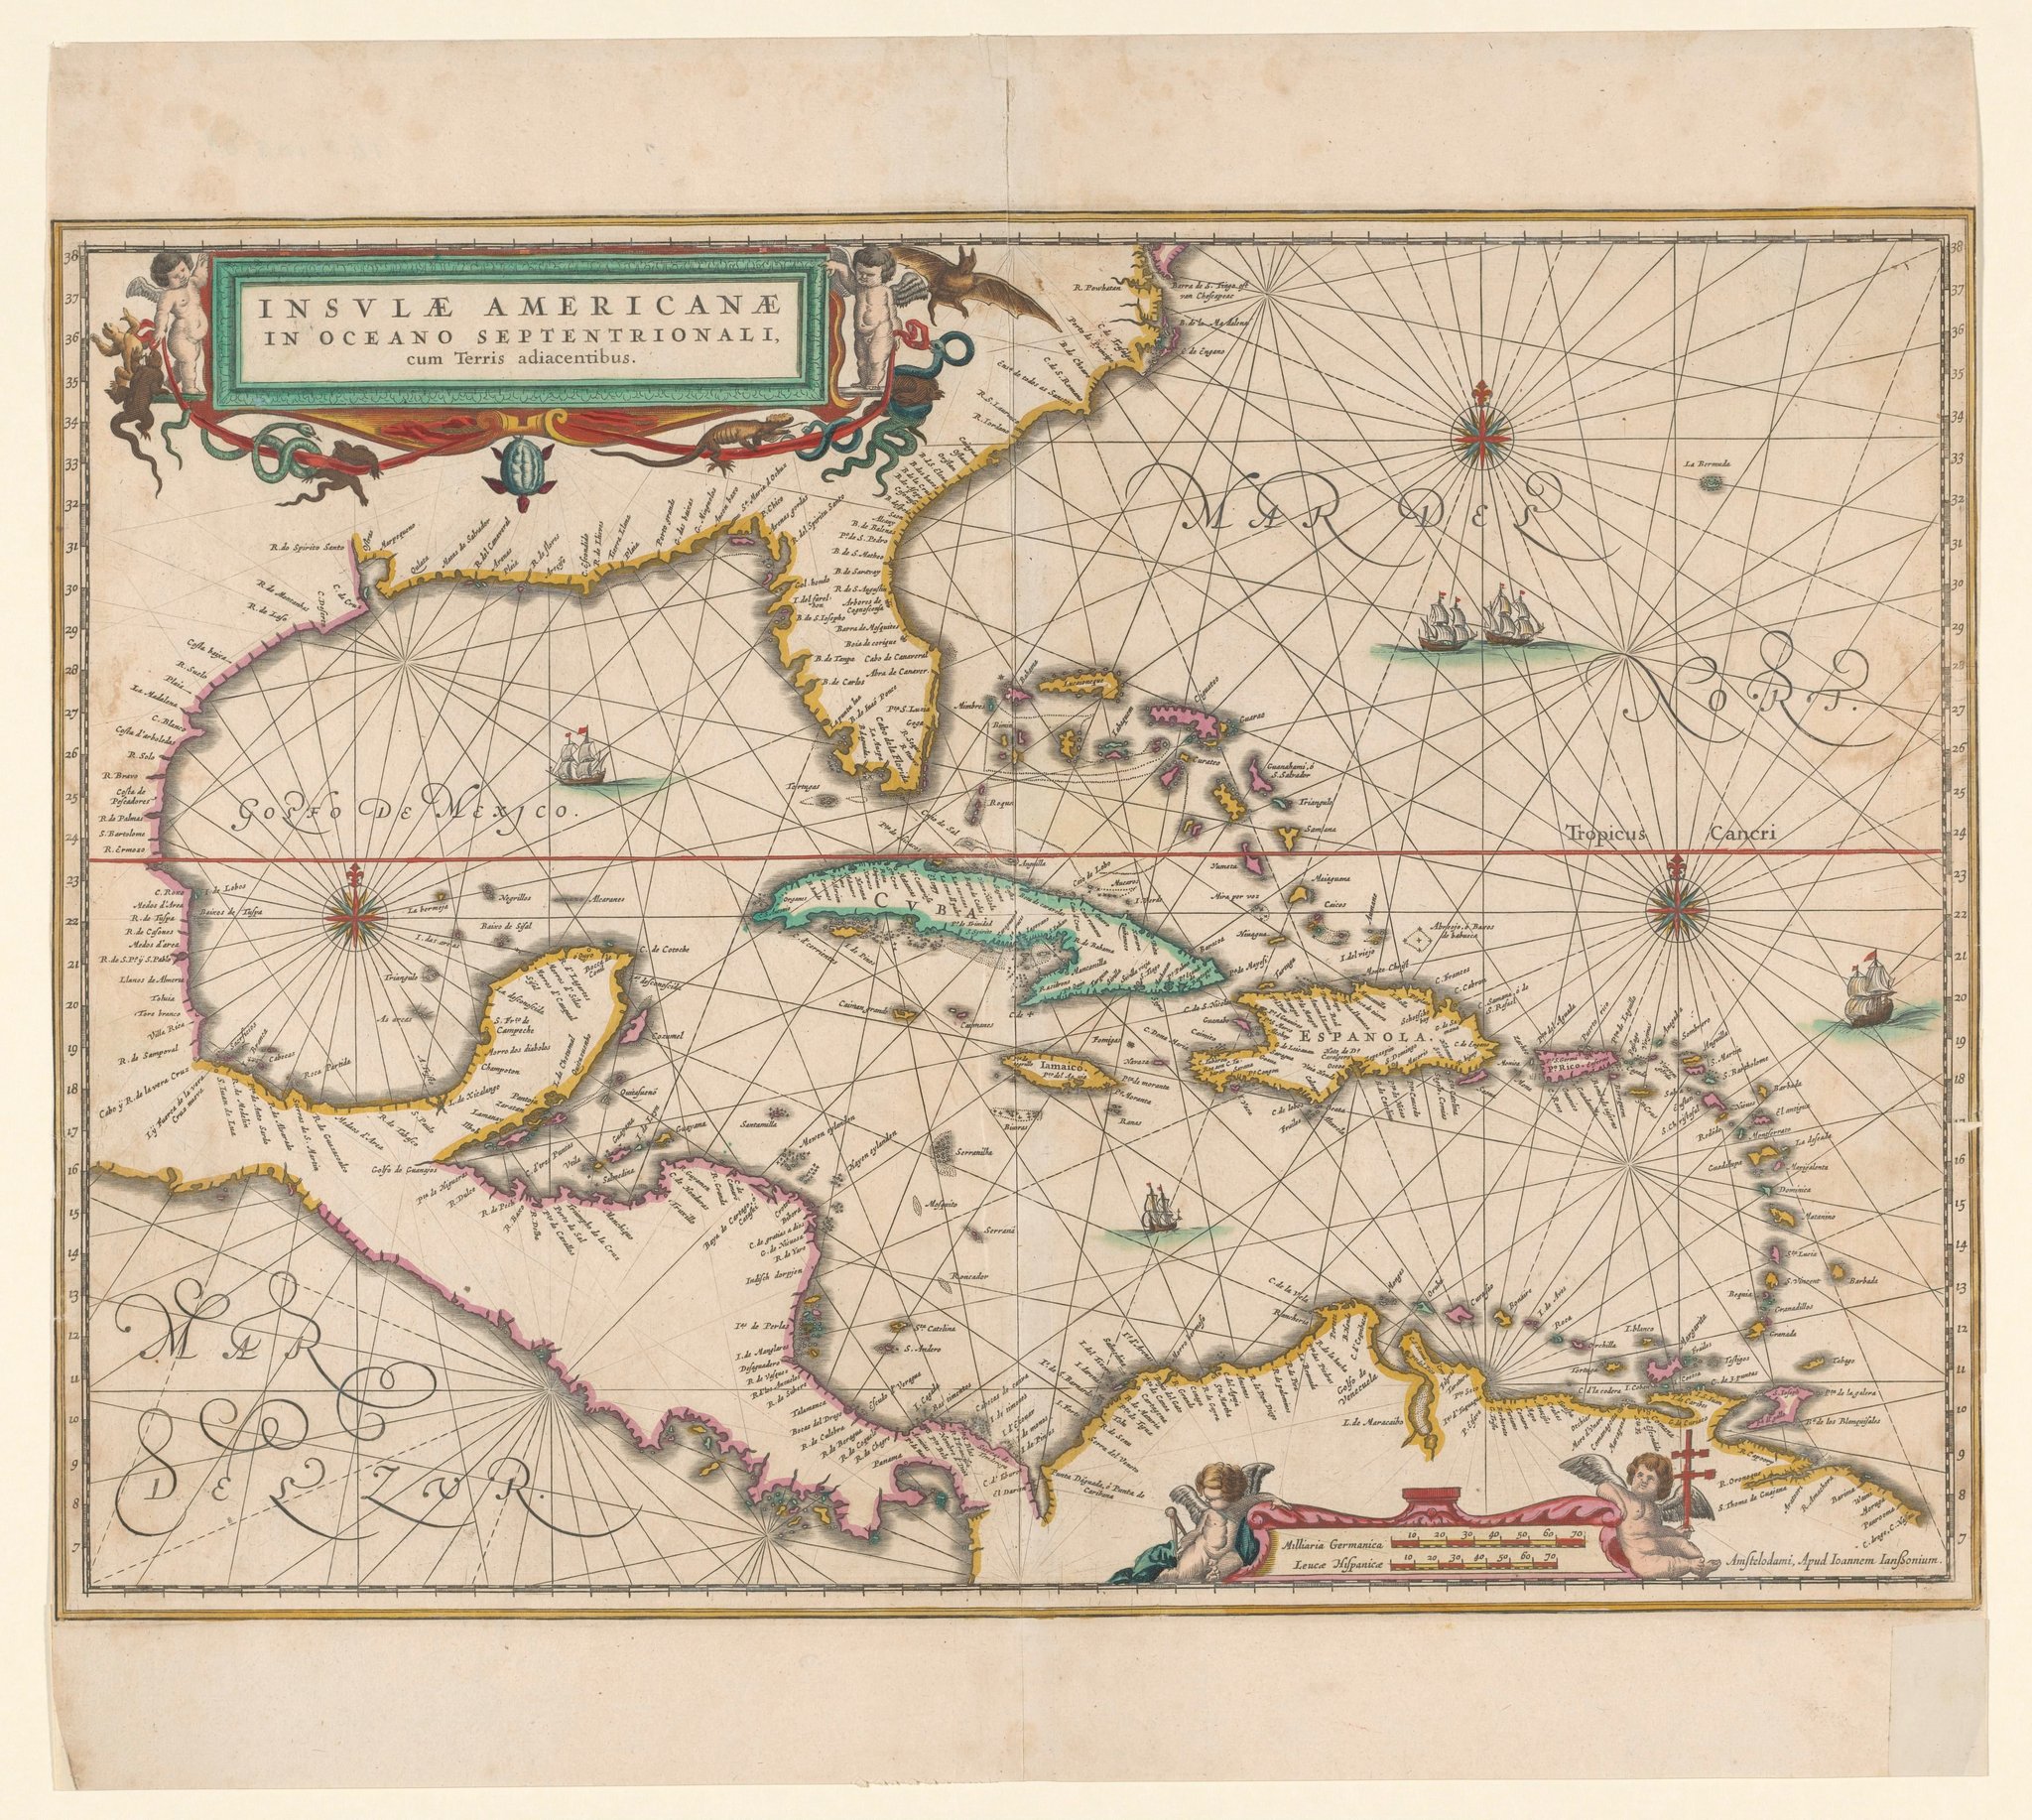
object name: map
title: Kaart van Midden-Amerika en het Caraïbisch gebied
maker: johannes janssonius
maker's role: publisher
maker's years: 1588-1664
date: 1640-1660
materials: paint, paper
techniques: engraving, hand coloring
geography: amsterdam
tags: maps of separate countries or regions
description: Kaart van Midden-Amerika en het Caraïbisch gebied. Linksboven cartouche met titel, geflankeerd door twee putti, slangen, vleermuizen en hagedissen. Rechtsonder twee schalen met links en rechts een putto.